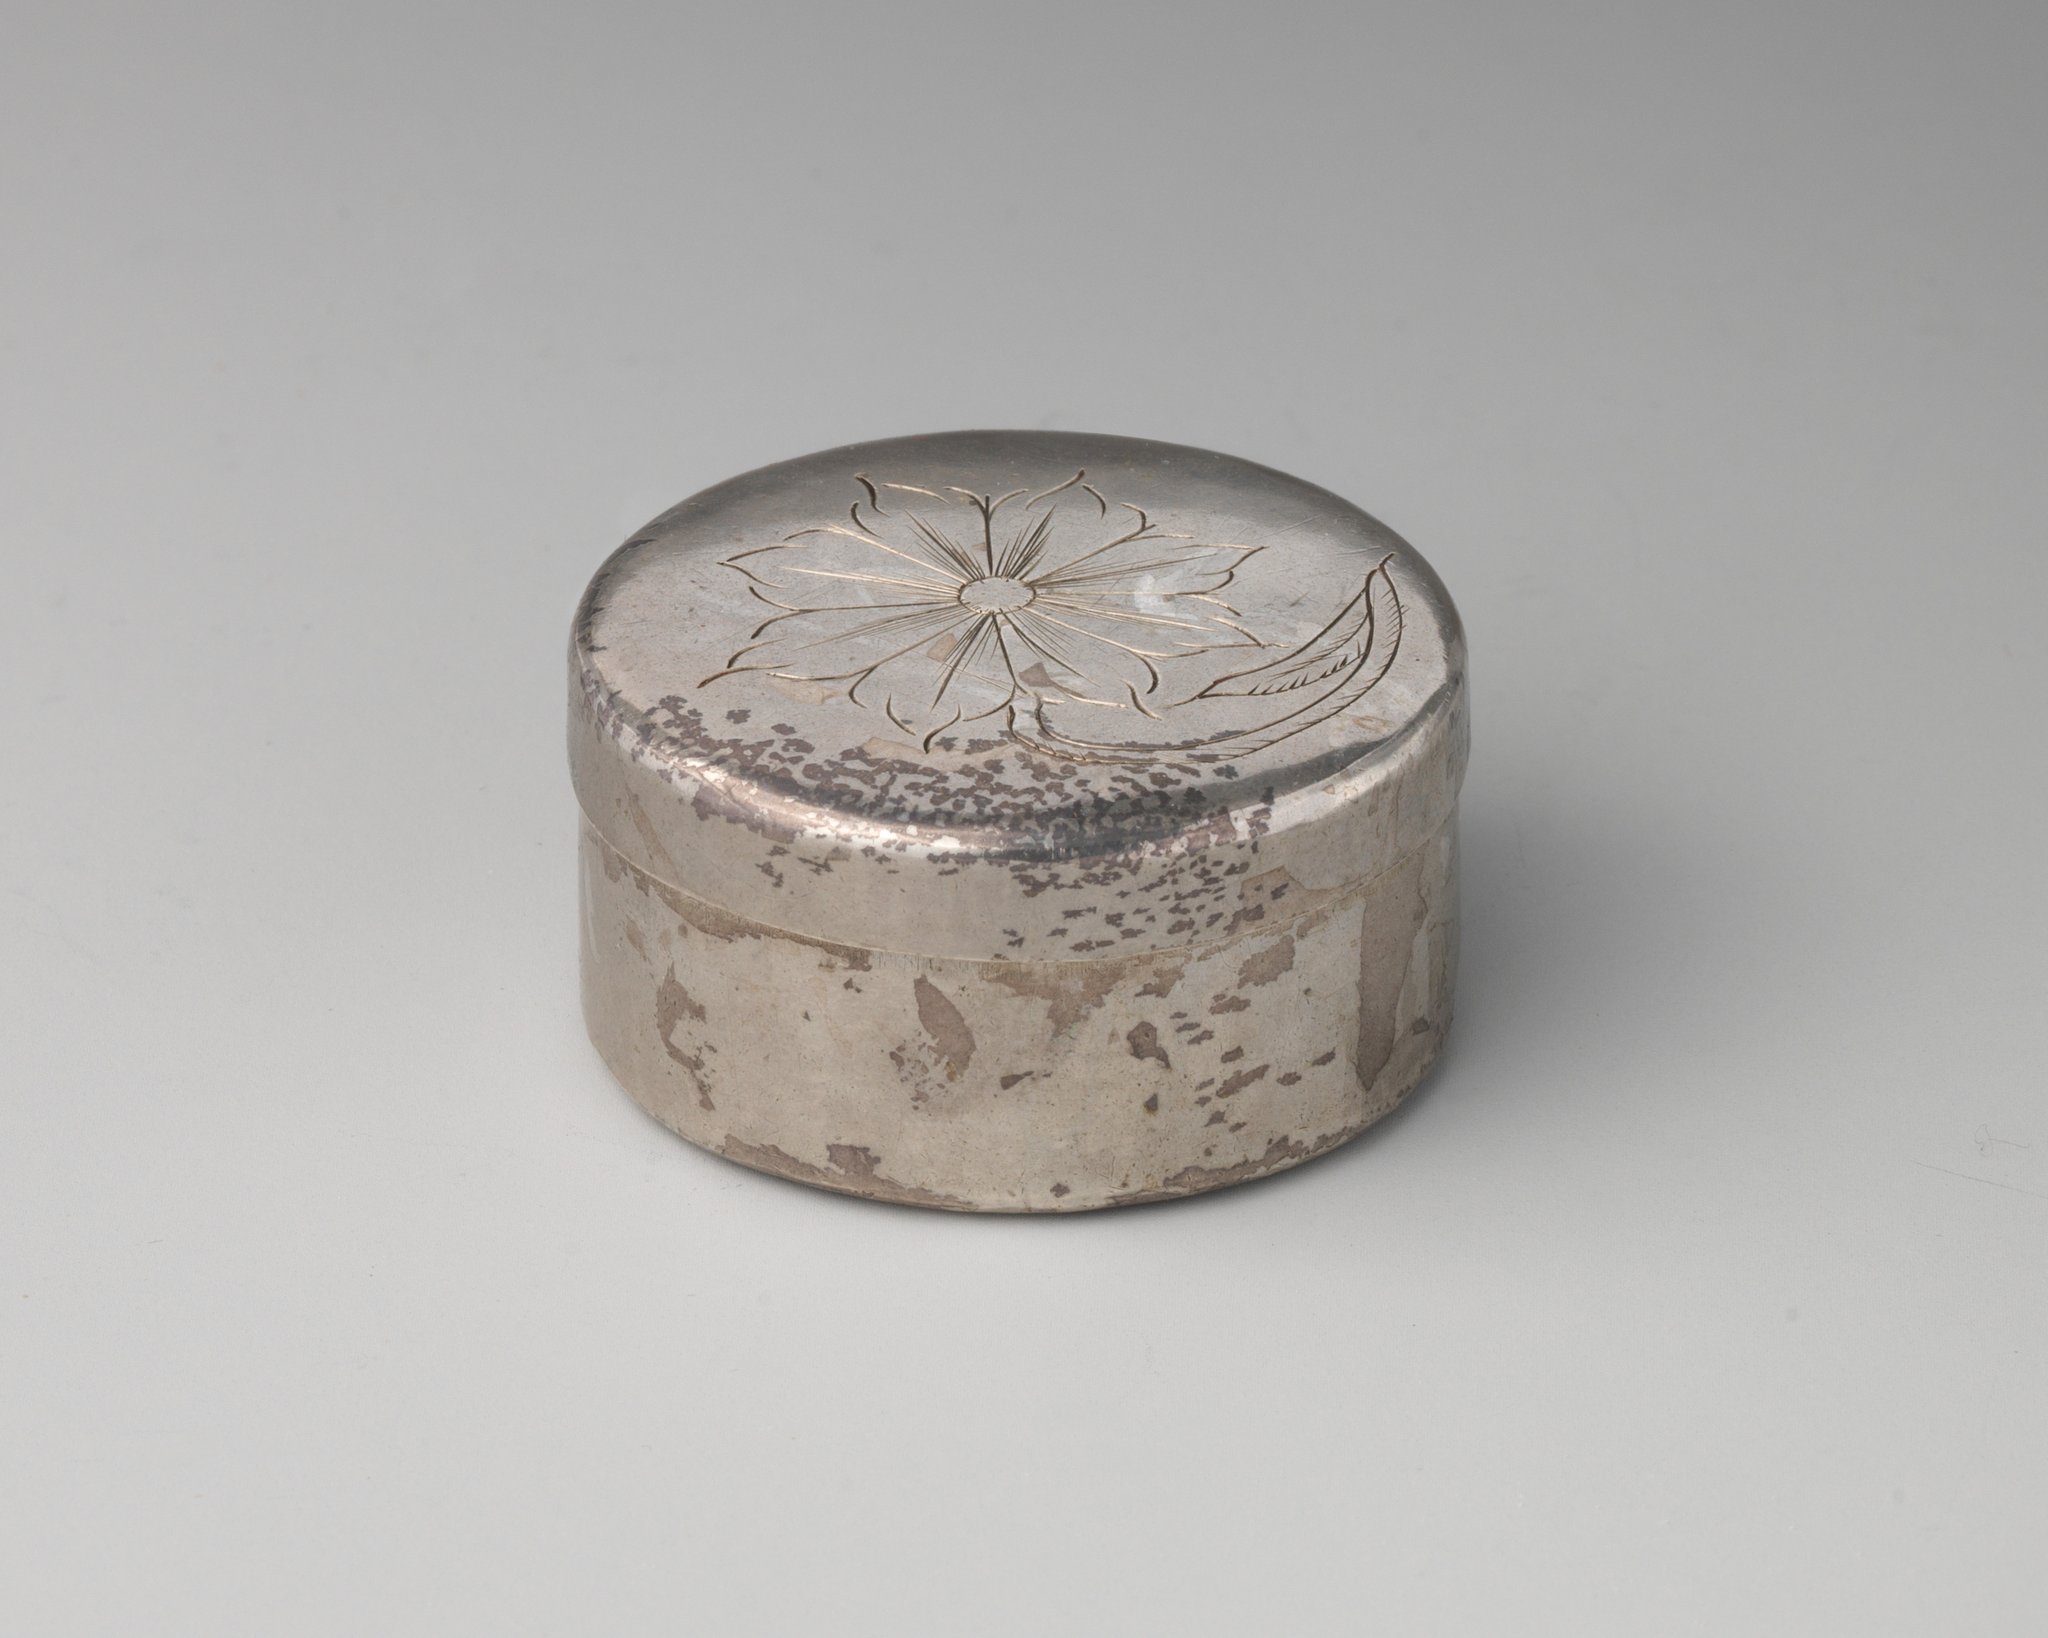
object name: wafer box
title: Miniature wafer box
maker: i. c., london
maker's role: maker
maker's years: 1686-1697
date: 1694-1695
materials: silver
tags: flowers